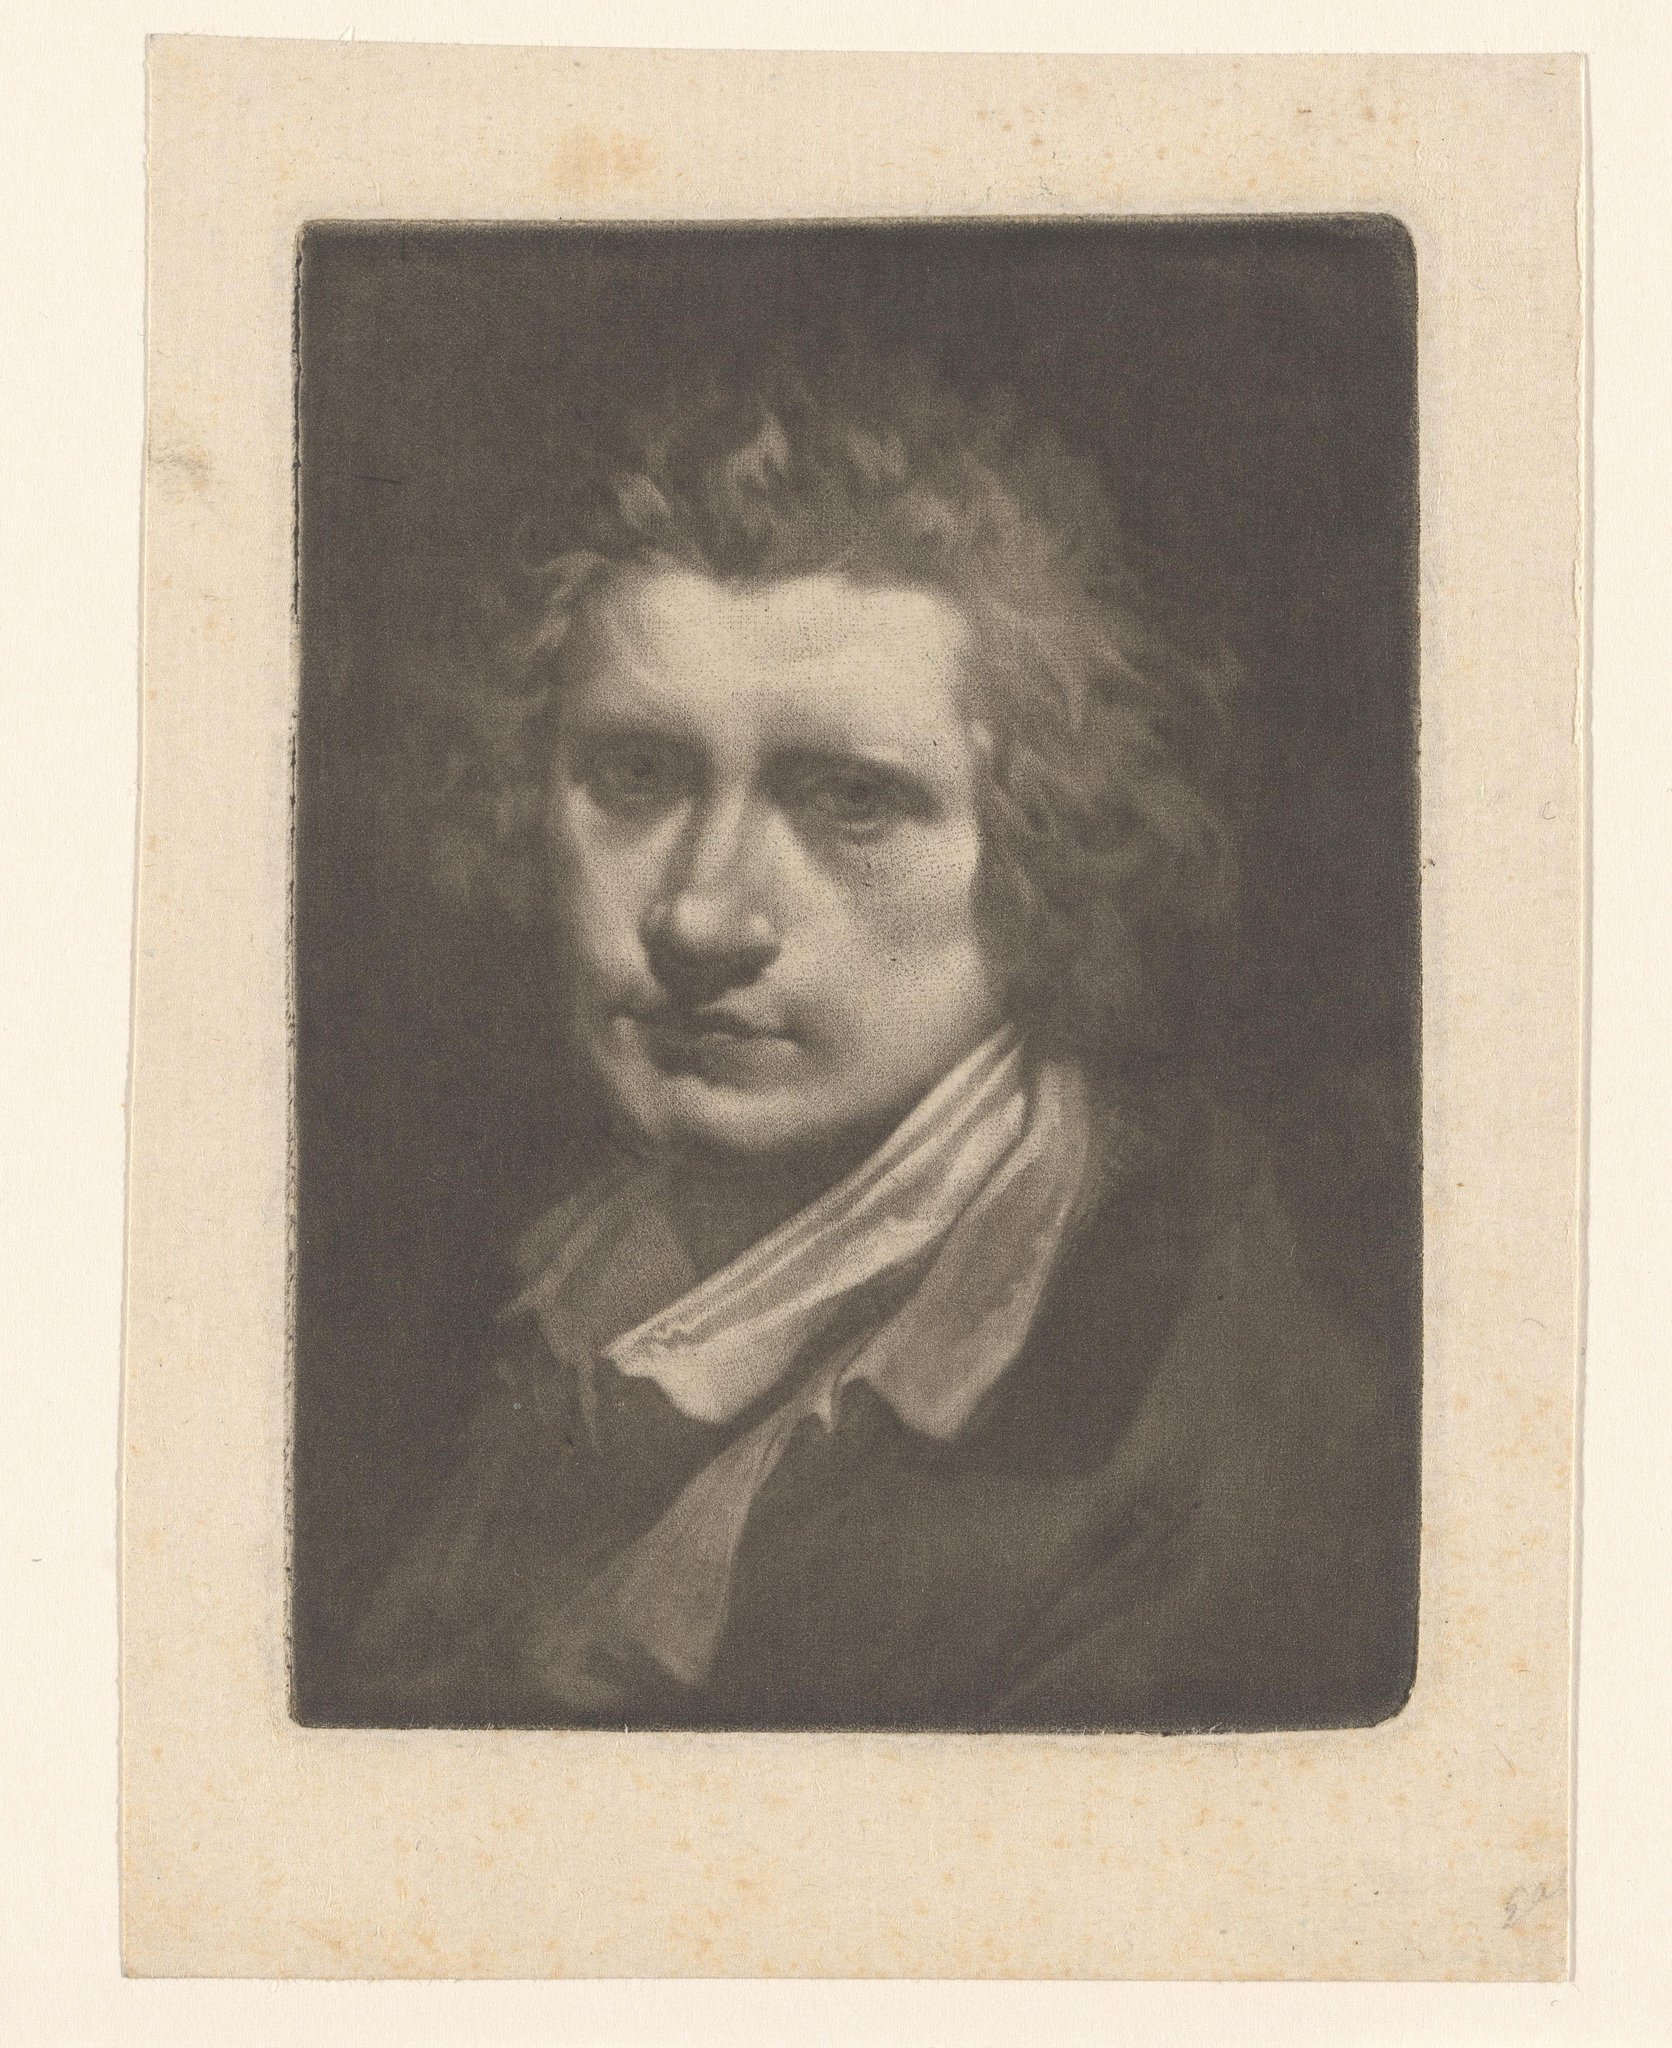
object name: print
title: Zelfportret van Johann Friedrich Bolt (?)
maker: johann friedrich bolt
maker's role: print maker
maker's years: 1769-1836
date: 1780-1800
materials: ink, paper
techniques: mezzotint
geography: germany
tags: berlin, johann friedrich bolt, historical persons, portrait, self-portrait of artist, graphic artist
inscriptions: collector's mark: Lugt 2228, collector's mark: Lugt 2656, collector's mark: Lugt 2760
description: Portretbuste. Vermoedelijk een zelfportret van de prentmaker Johann Friedrich Bolt.